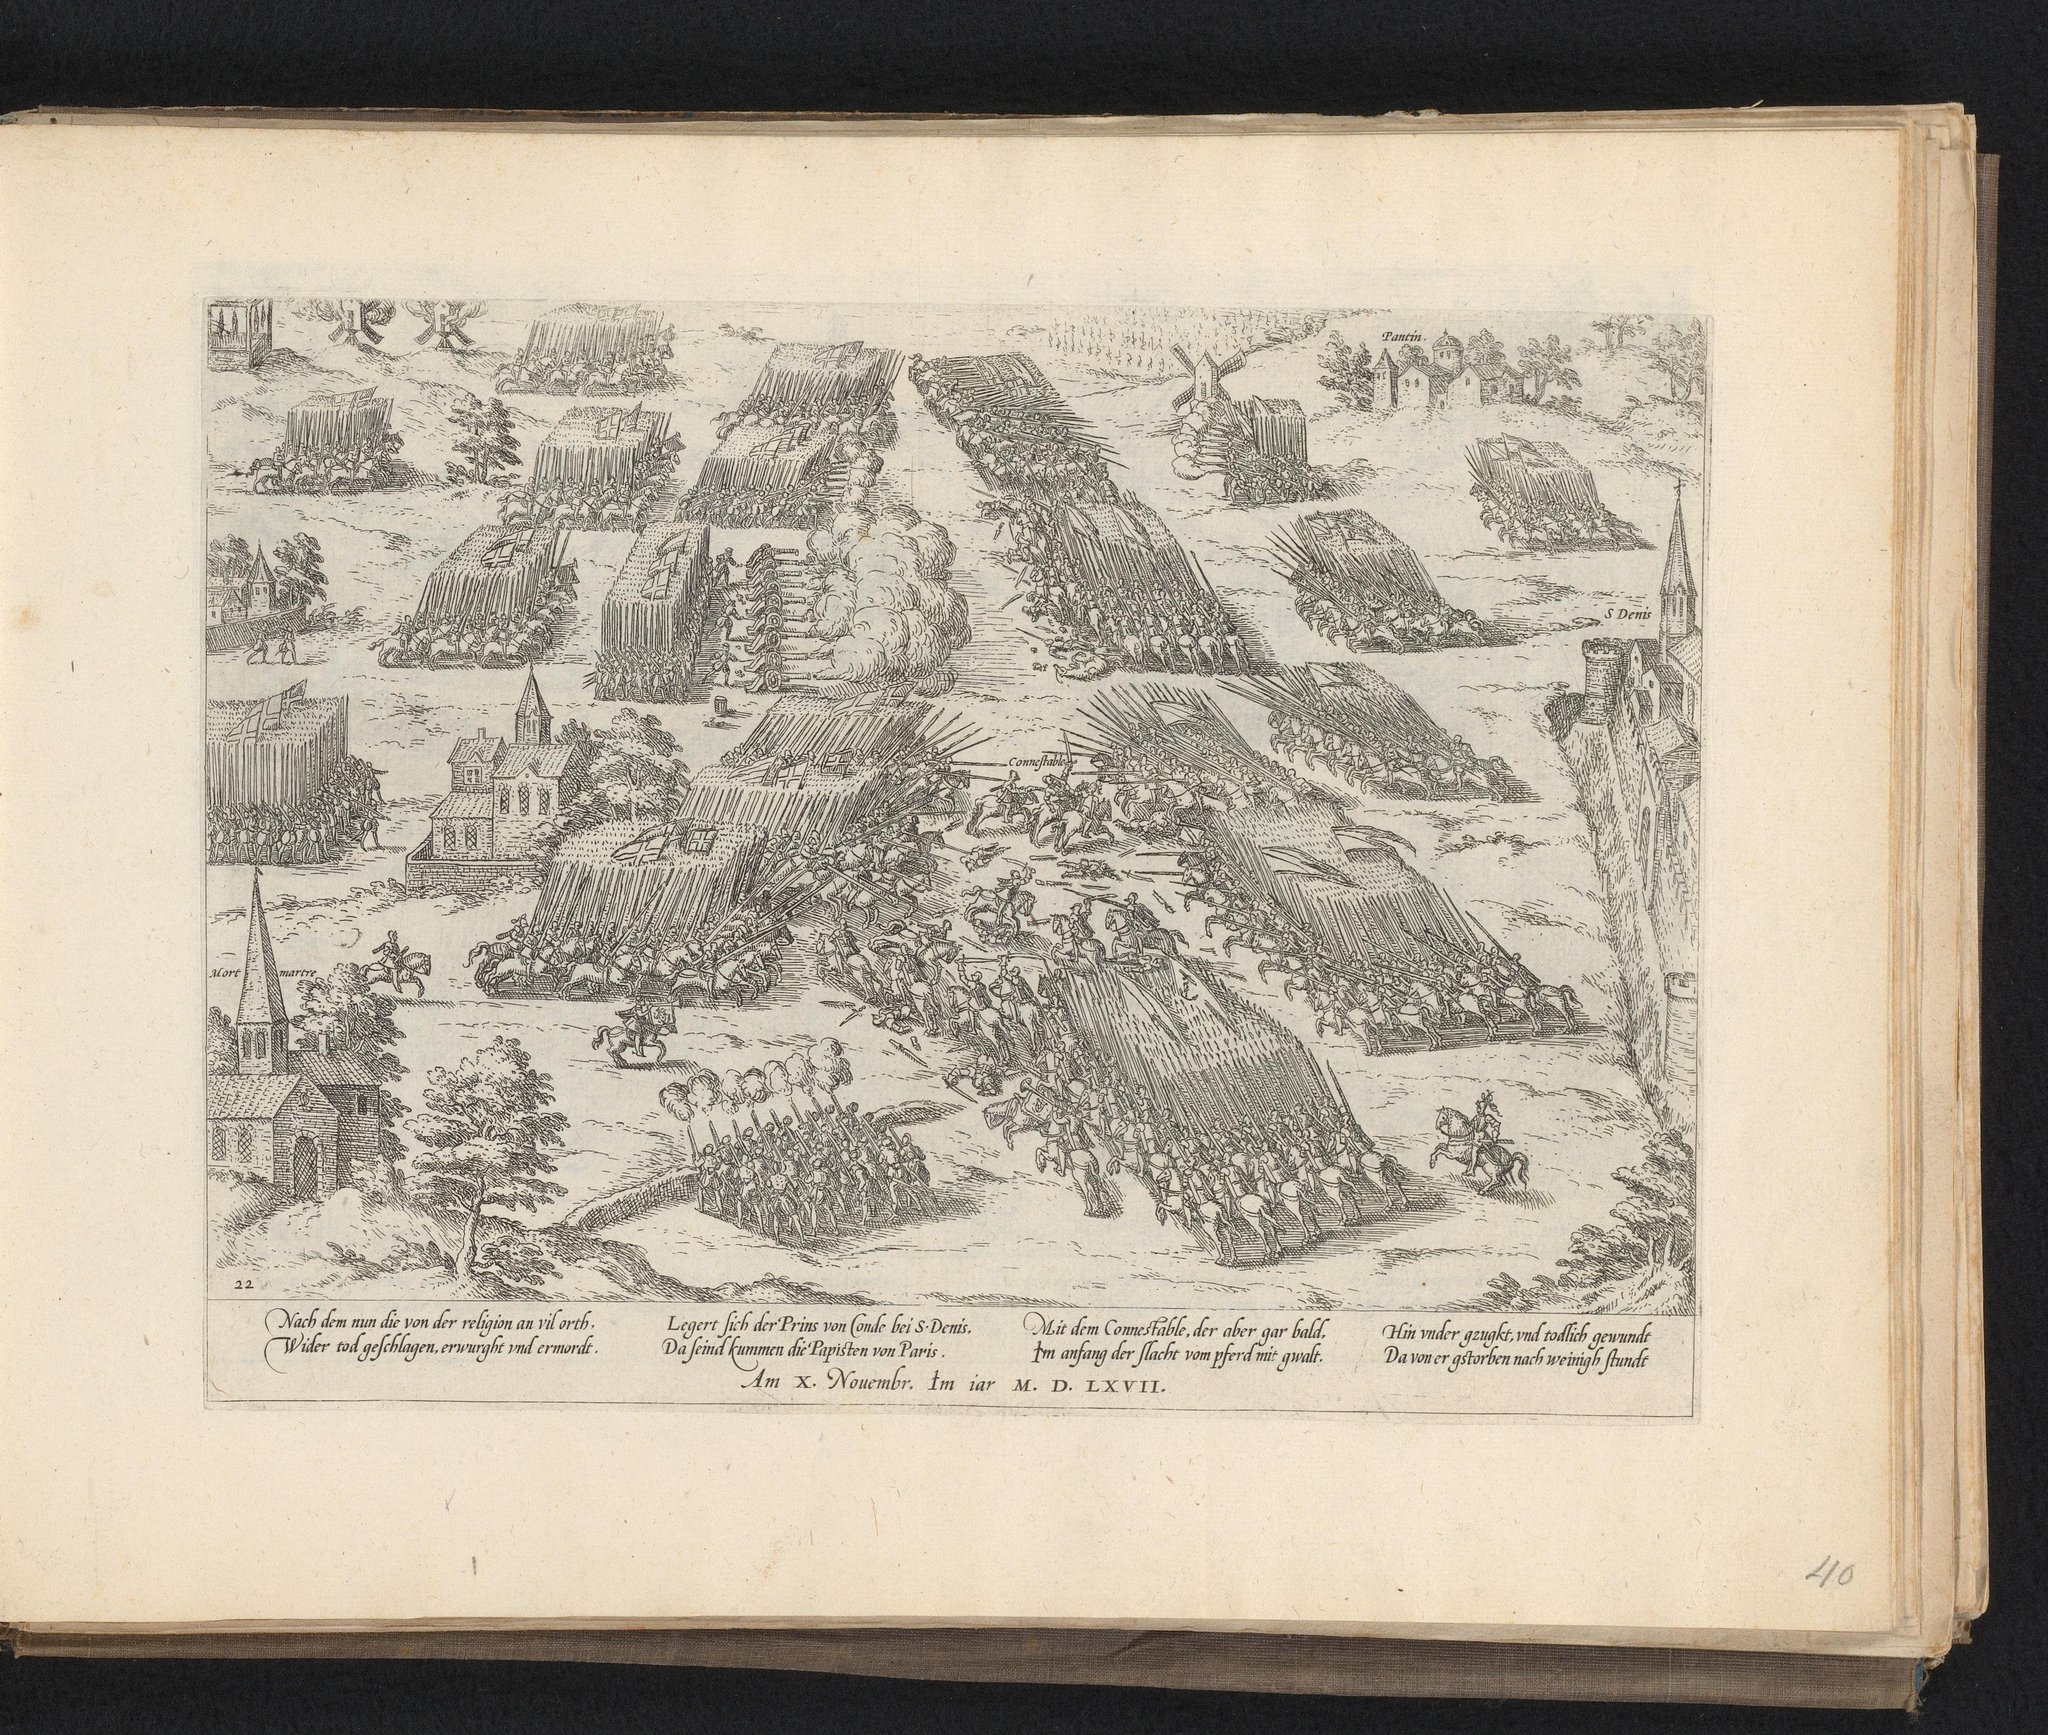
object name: print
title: Serie 3: Franse Godsdienstoorlogen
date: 1567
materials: paper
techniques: etching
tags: militant proselytizing: religious war, crusade, etc., battle (+ land forces), the roman catholic church vs. protestantism; (reformation and counter reformation)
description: Prent gebruikt in: Aitsinger, Michael. De Leone Belgico (...). Keulen: s.n., 1588.